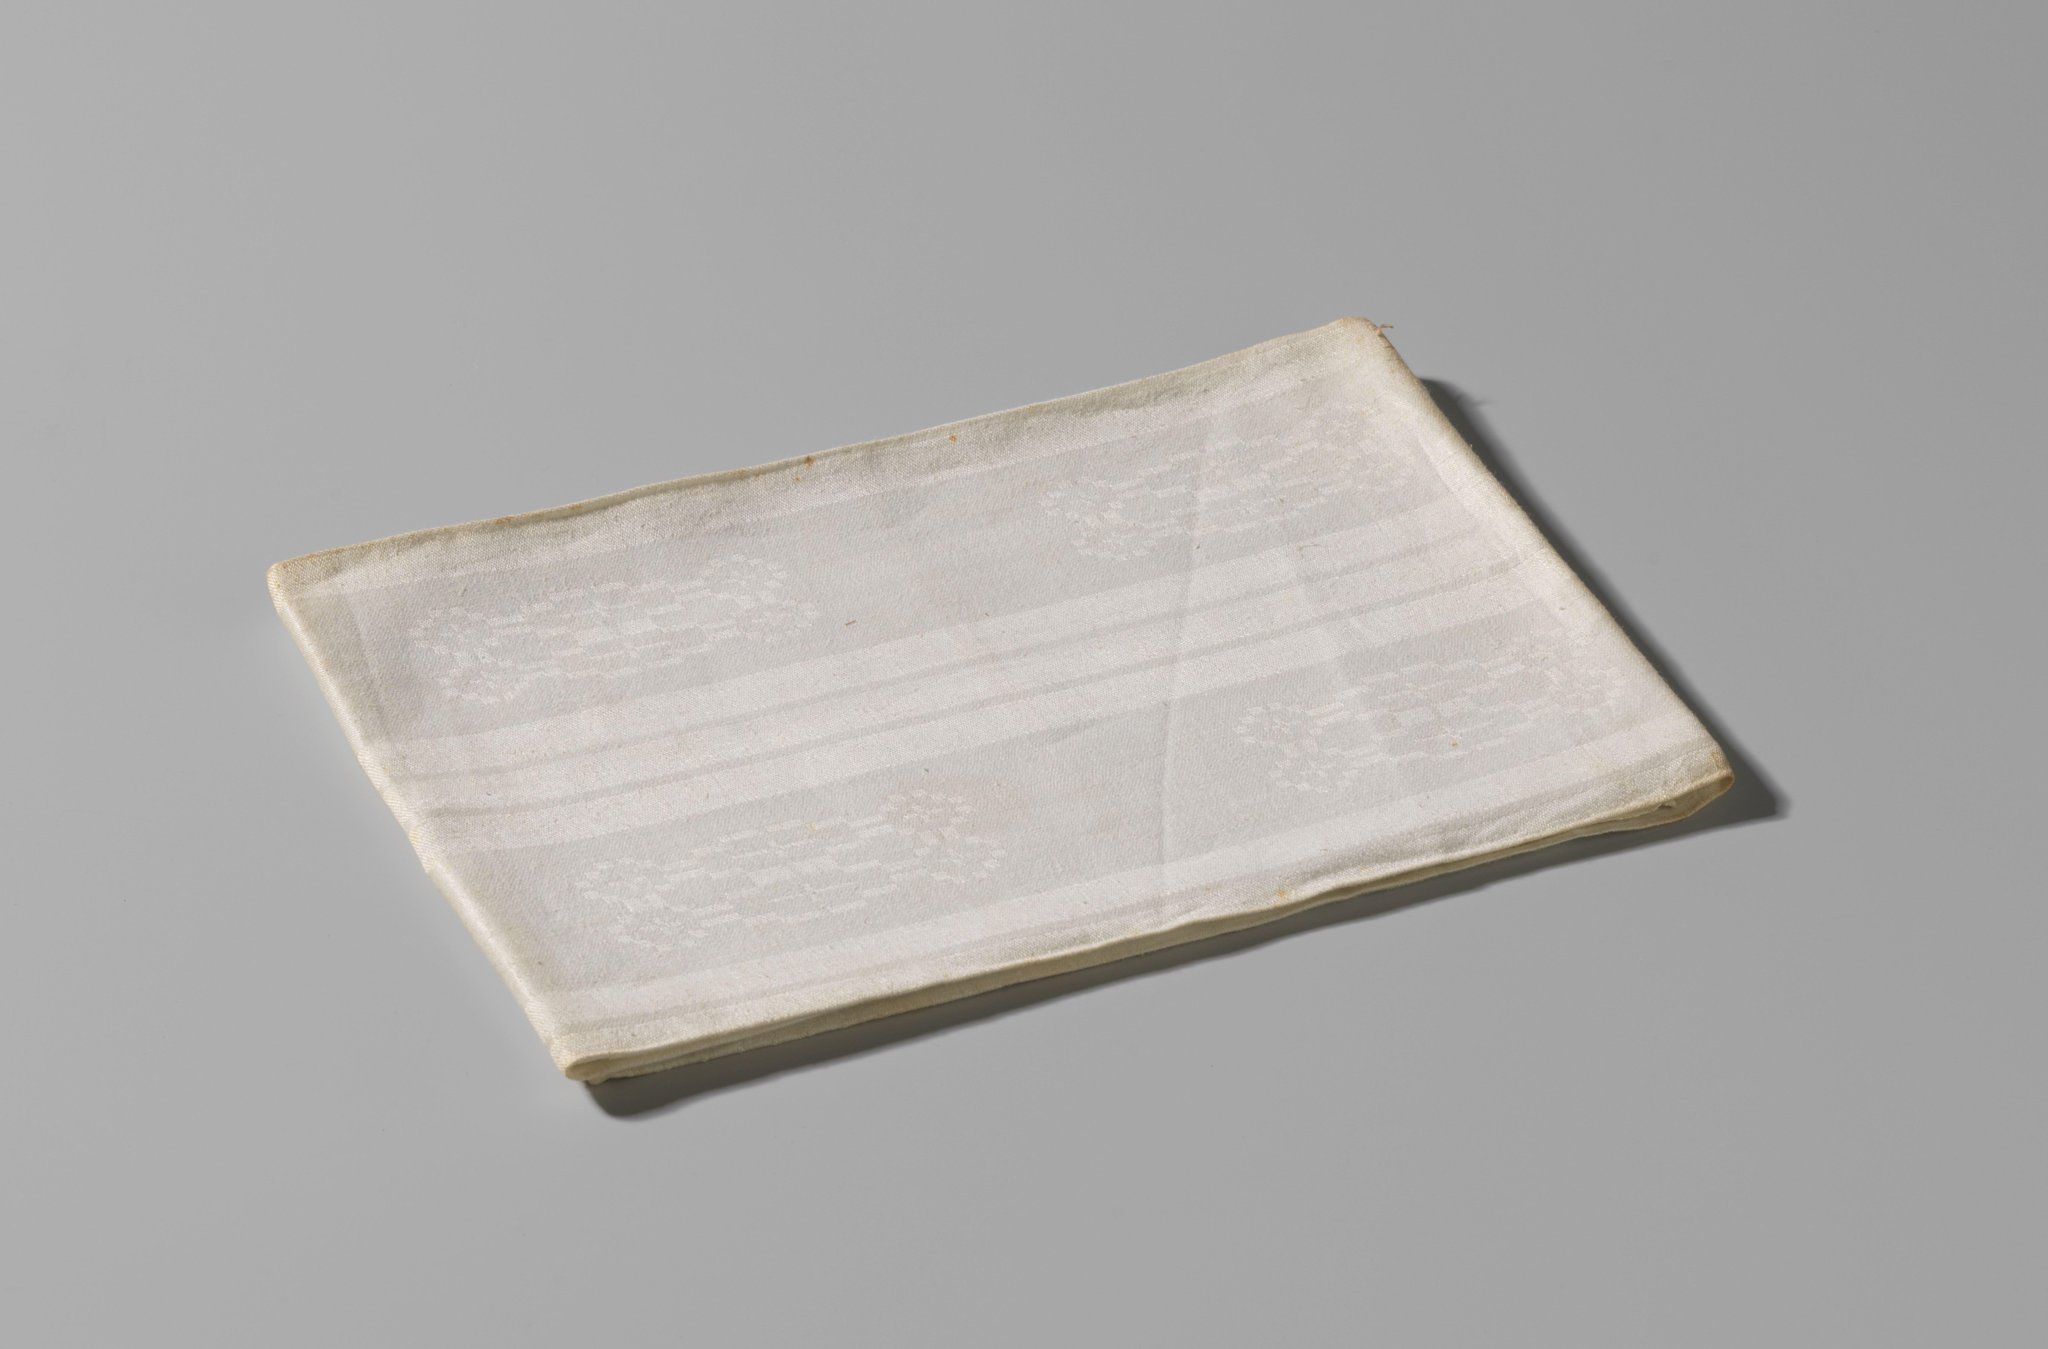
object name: napkin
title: Pellen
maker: Anonymous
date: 1800-1900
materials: linen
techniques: damask, weave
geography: netherlands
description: Servet van linnen pellendamast met randen rondom en in een hoek gemerkt met in rode kruissteek: PK 12.